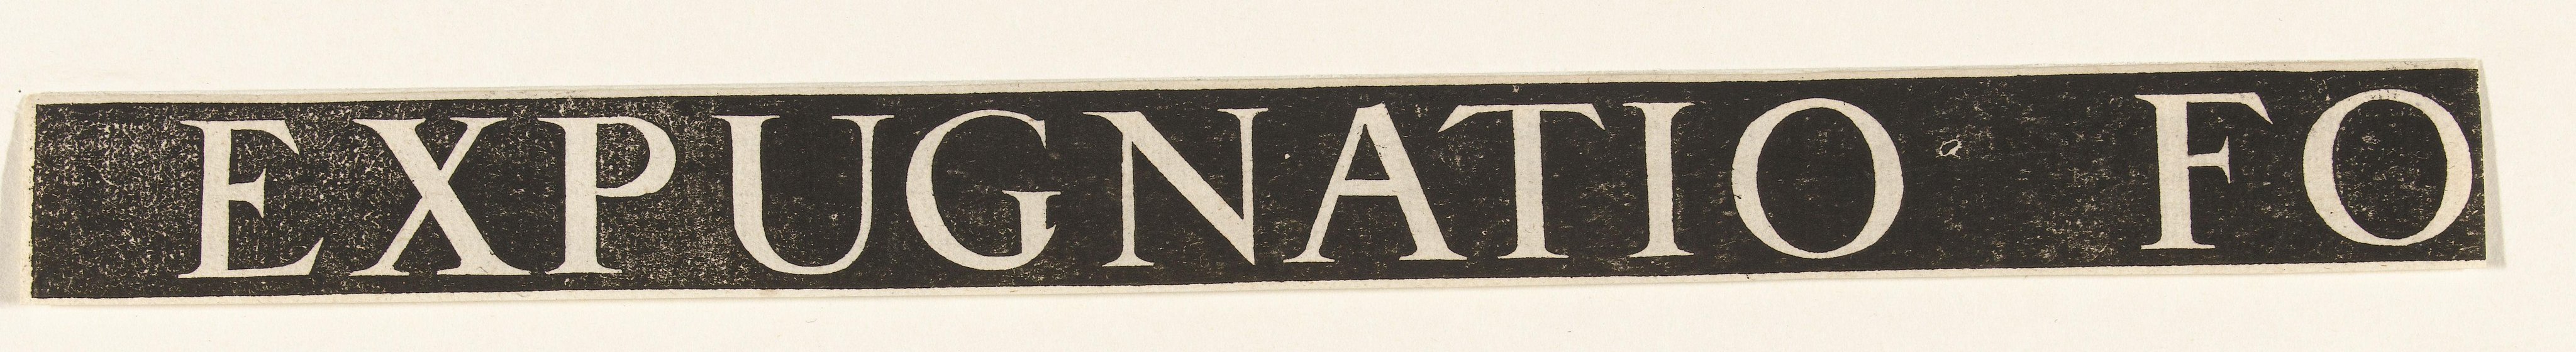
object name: print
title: Expugnatio Fortissimae Arcis Gennapae. Ao Domini MDCXXXXI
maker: claes jansz. visscher (ii)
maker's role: draughtsman, print maker, publisher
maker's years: 1586-1652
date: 1641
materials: paper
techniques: woodcut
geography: amsterdam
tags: the hague, frederick henry (prince of orange)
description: Titel (eerste strook) voor het grote ensemble van het beleg en de verovering van het Huis te Gennep door het Staatse leger onder Frederik Hendrik, 6 juni - 27 juli 1641. Onderdeel van een ensemble bestaande uit een titel in 4 stroken, de 4 platen uit het atelier van Visscher, de 4 bladen van het vertrek van het garnizoen door Nolpe en ongeveer 7 tekstbladen.